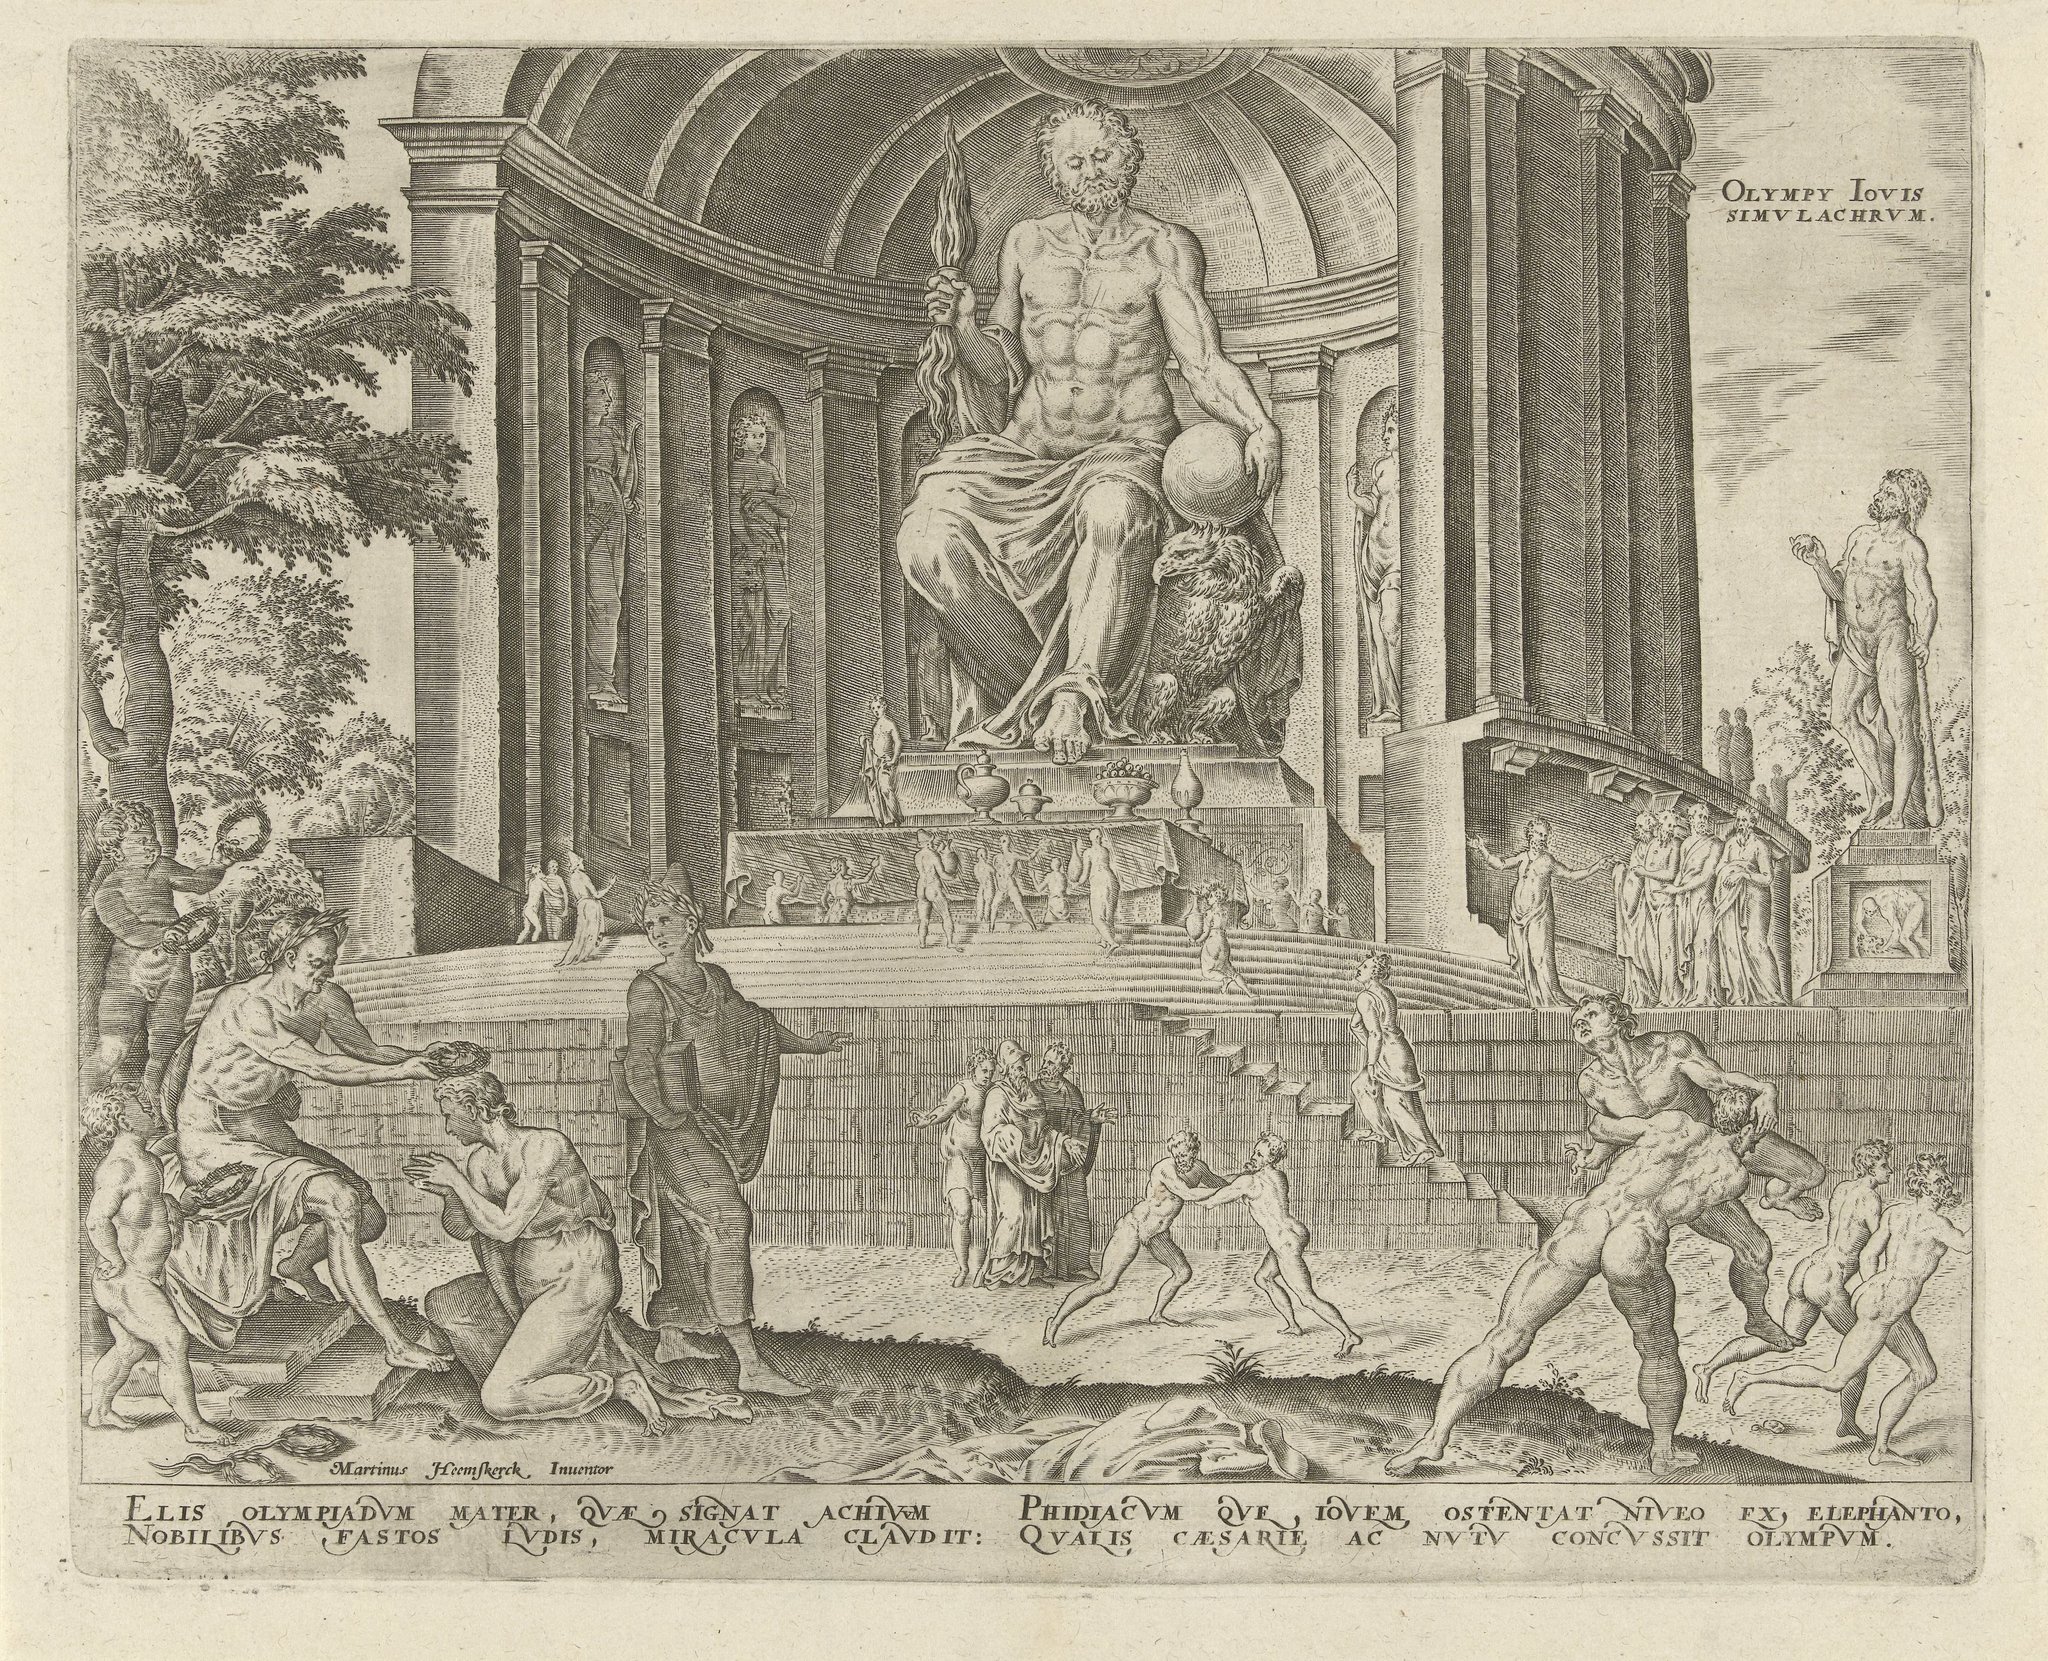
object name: print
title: Olympy Iovis simvlacrvm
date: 1572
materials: paper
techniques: engraving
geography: haarlem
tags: (story of) hercules (heracles), wrestling (sport), olympic games, in honour of zeus, statue of zeus by phidias (wonder of the world)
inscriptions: collector's mark: Lugt 2228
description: Het beeld van Zeus bevond zich binnen in de Dorische tempel van Olympia, op de Griekse Peloponnesus. Het werd omstreeks 433 v. Chr. gemaakt door de Atheense beeldhouwer Phidias. Rechts van de tempel een beeld van Hercules. Op de trappen voor de tempel mensen die het beeld van Zeus aanbidden. Op de voorgrond rechts Olympische worstelaars en renners, links wordt een van de winnaars gelauwerd. De prent heeft een Latijns onderschrift en maakt deel uit van een serie over de acht wereldwonderen.